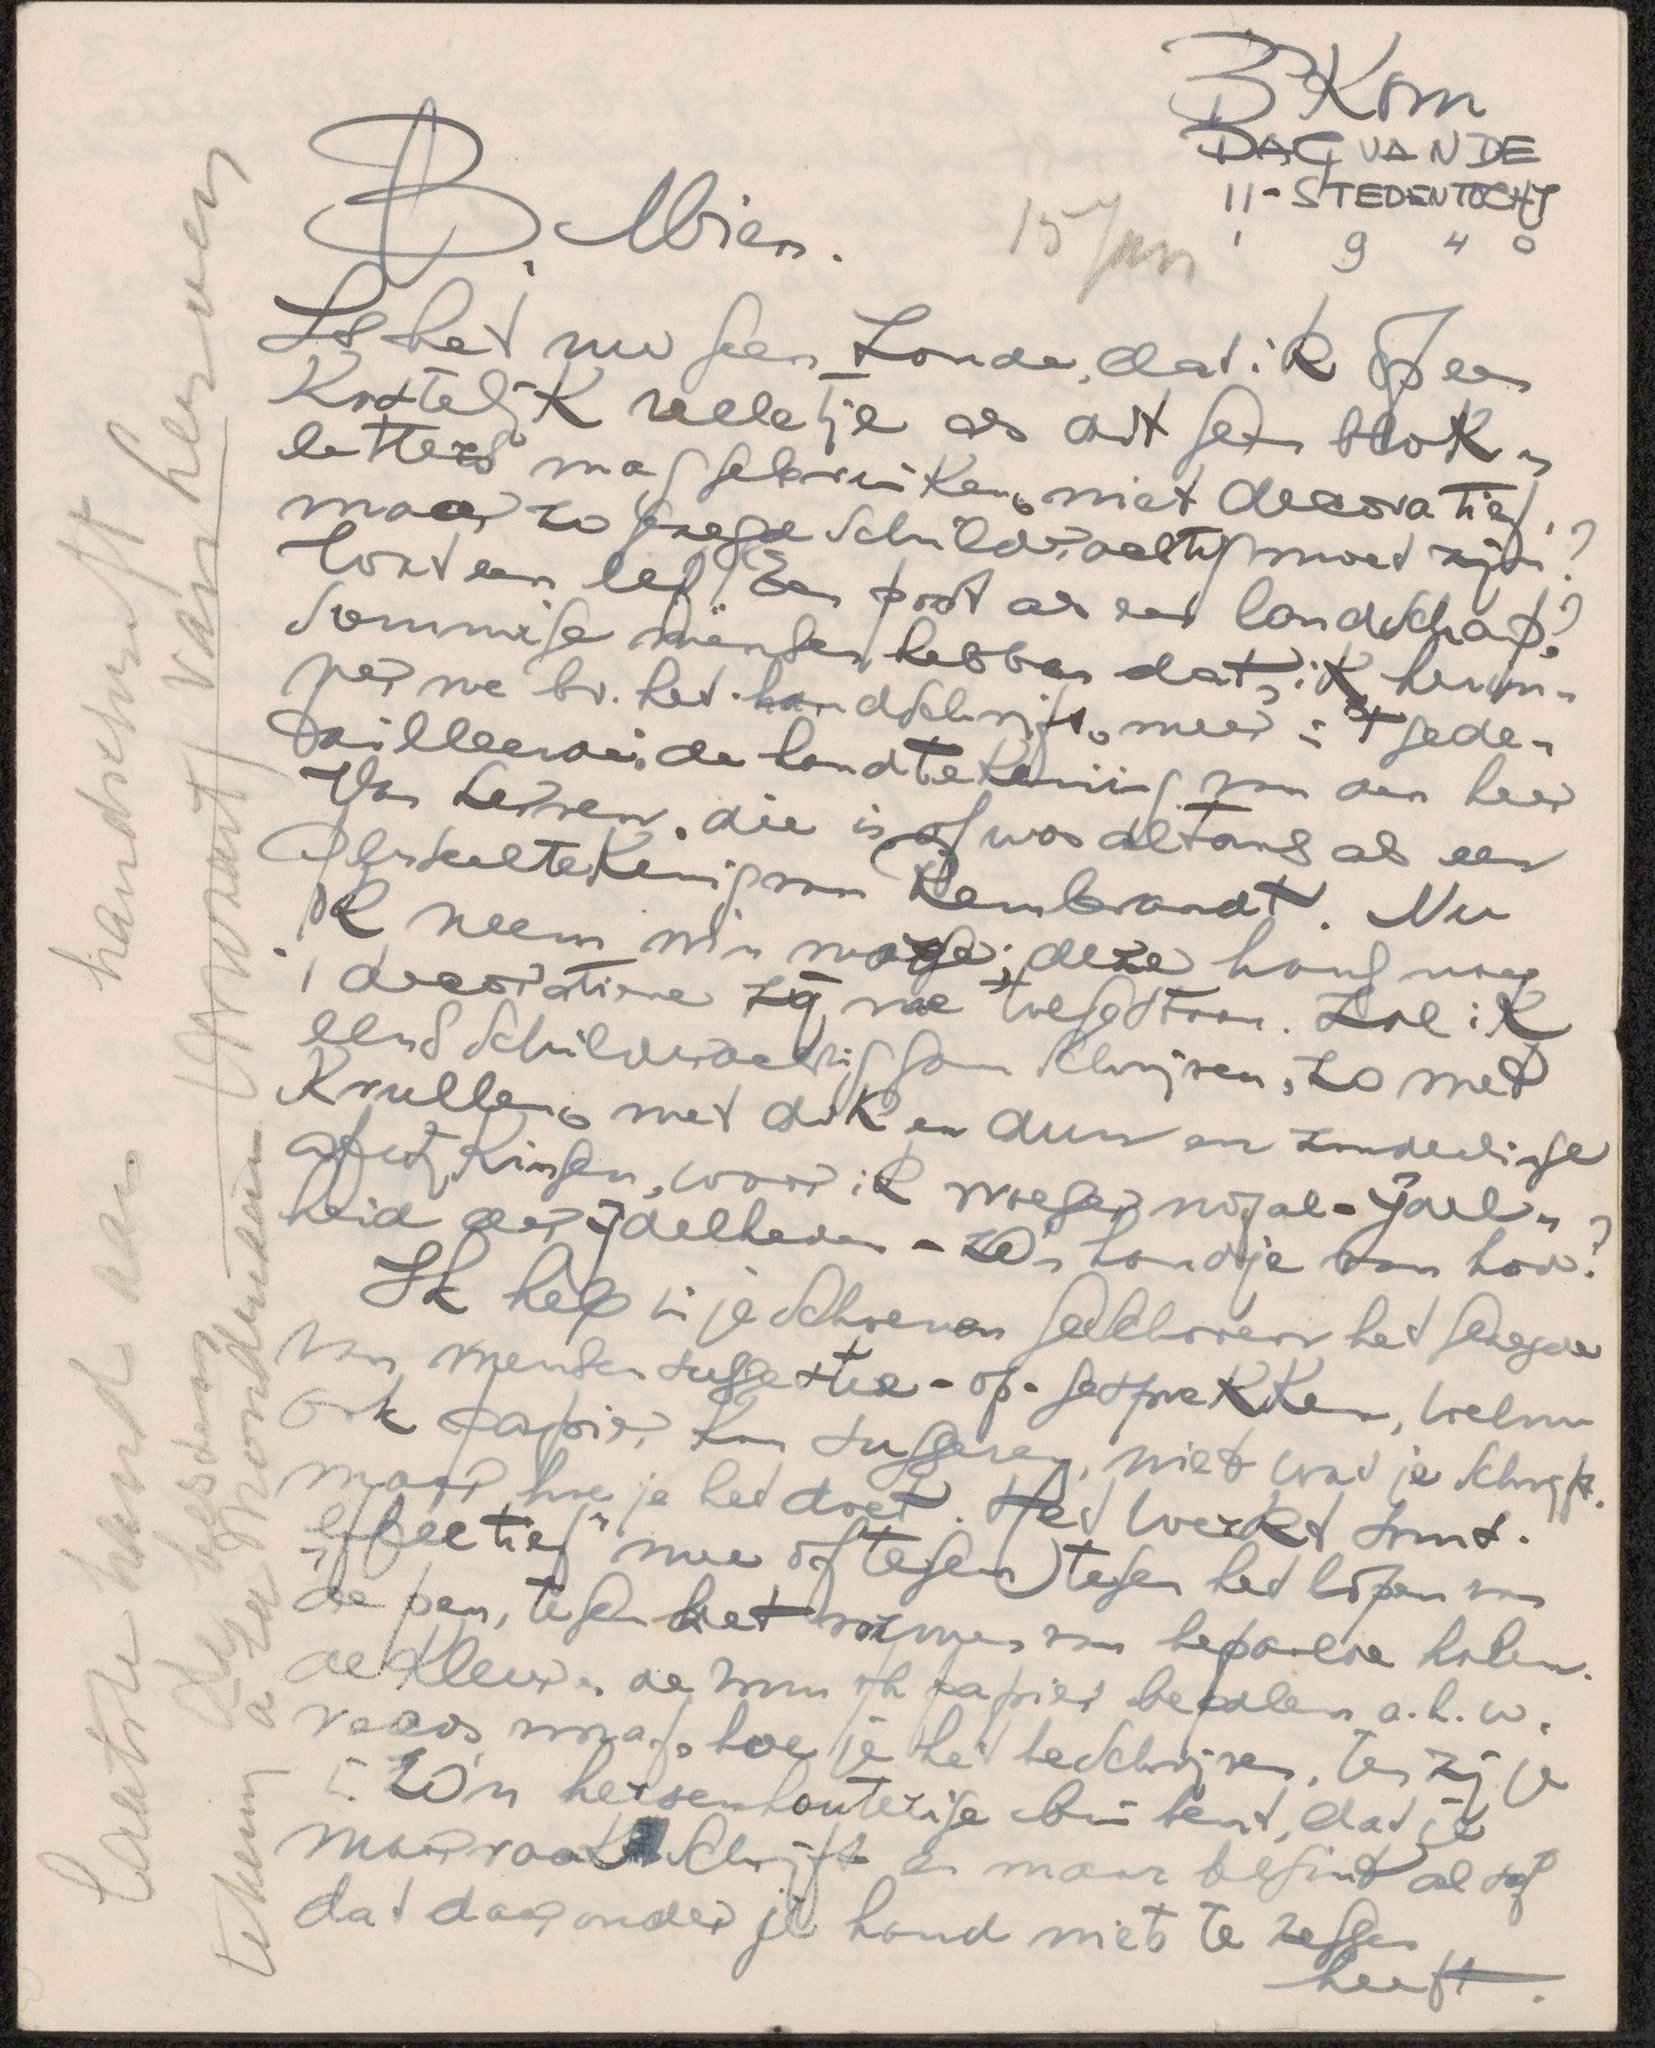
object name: letter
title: Brief aan Mien Cambier van Nooten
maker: dick ket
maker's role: draughtsman, print maker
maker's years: 1902-1940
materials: chalk, ink, paper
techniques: pen, writing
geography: bennekom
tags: arnhem, mien cambier van nooten, piet mondriaan, johan mekkink, abstract, non-representational art, music, eleven cities tour